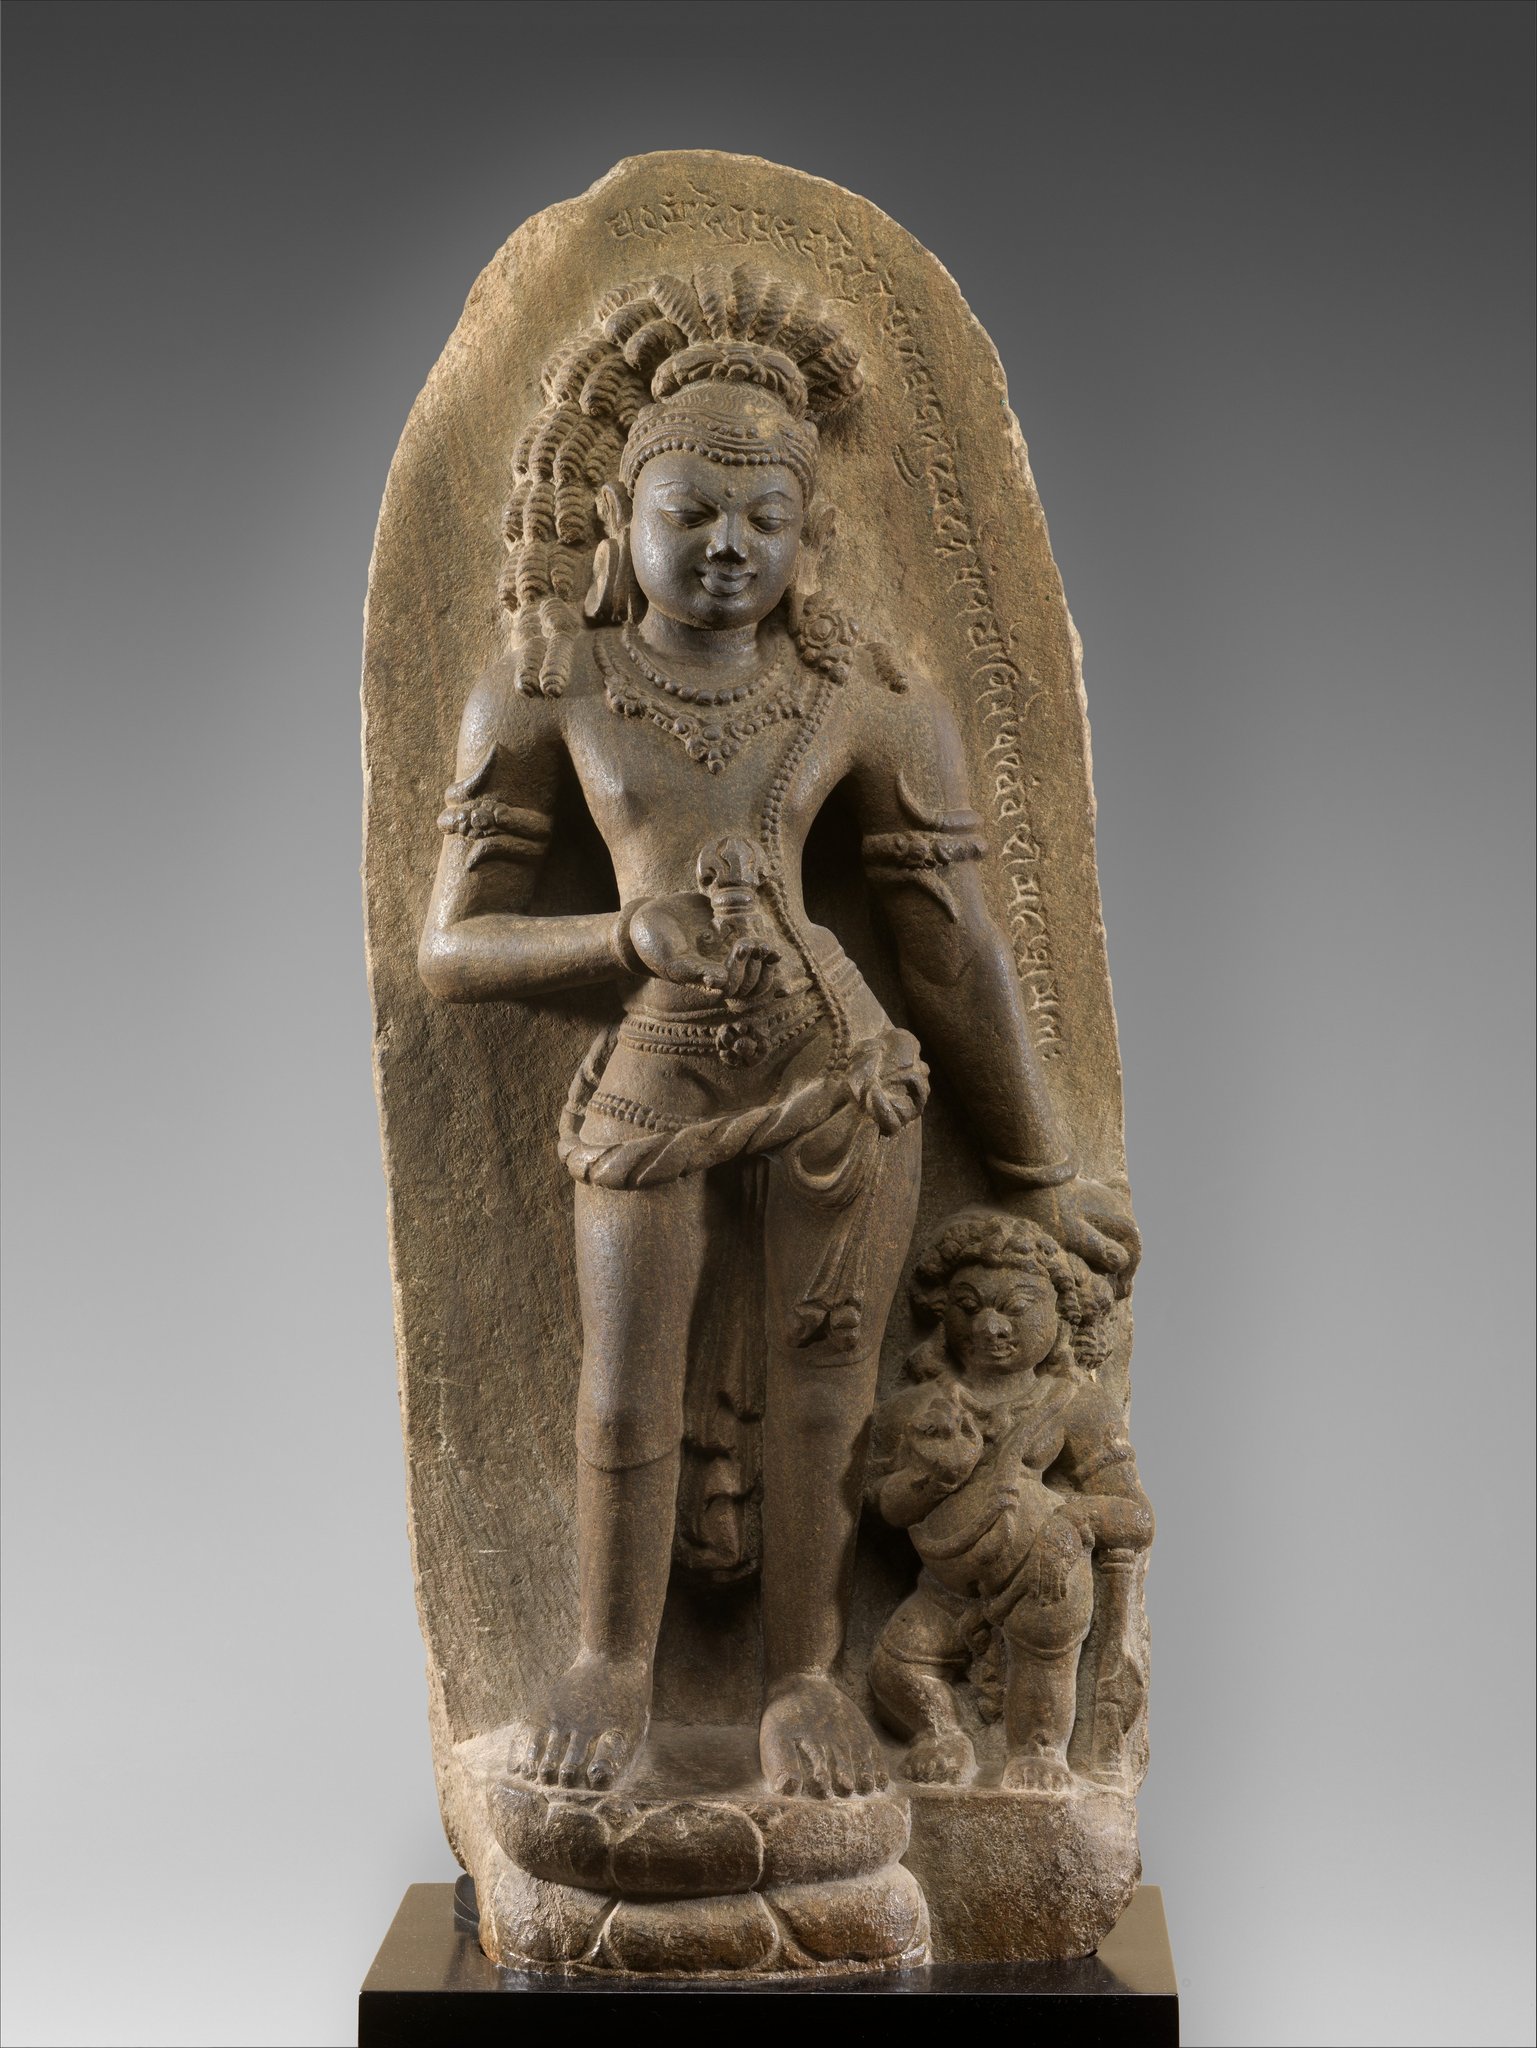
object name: stele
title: The Bodhisattva Vajrapani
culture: eastern indian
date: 601-733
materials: stone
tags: buddhism,bodhisattvas,vajrapani